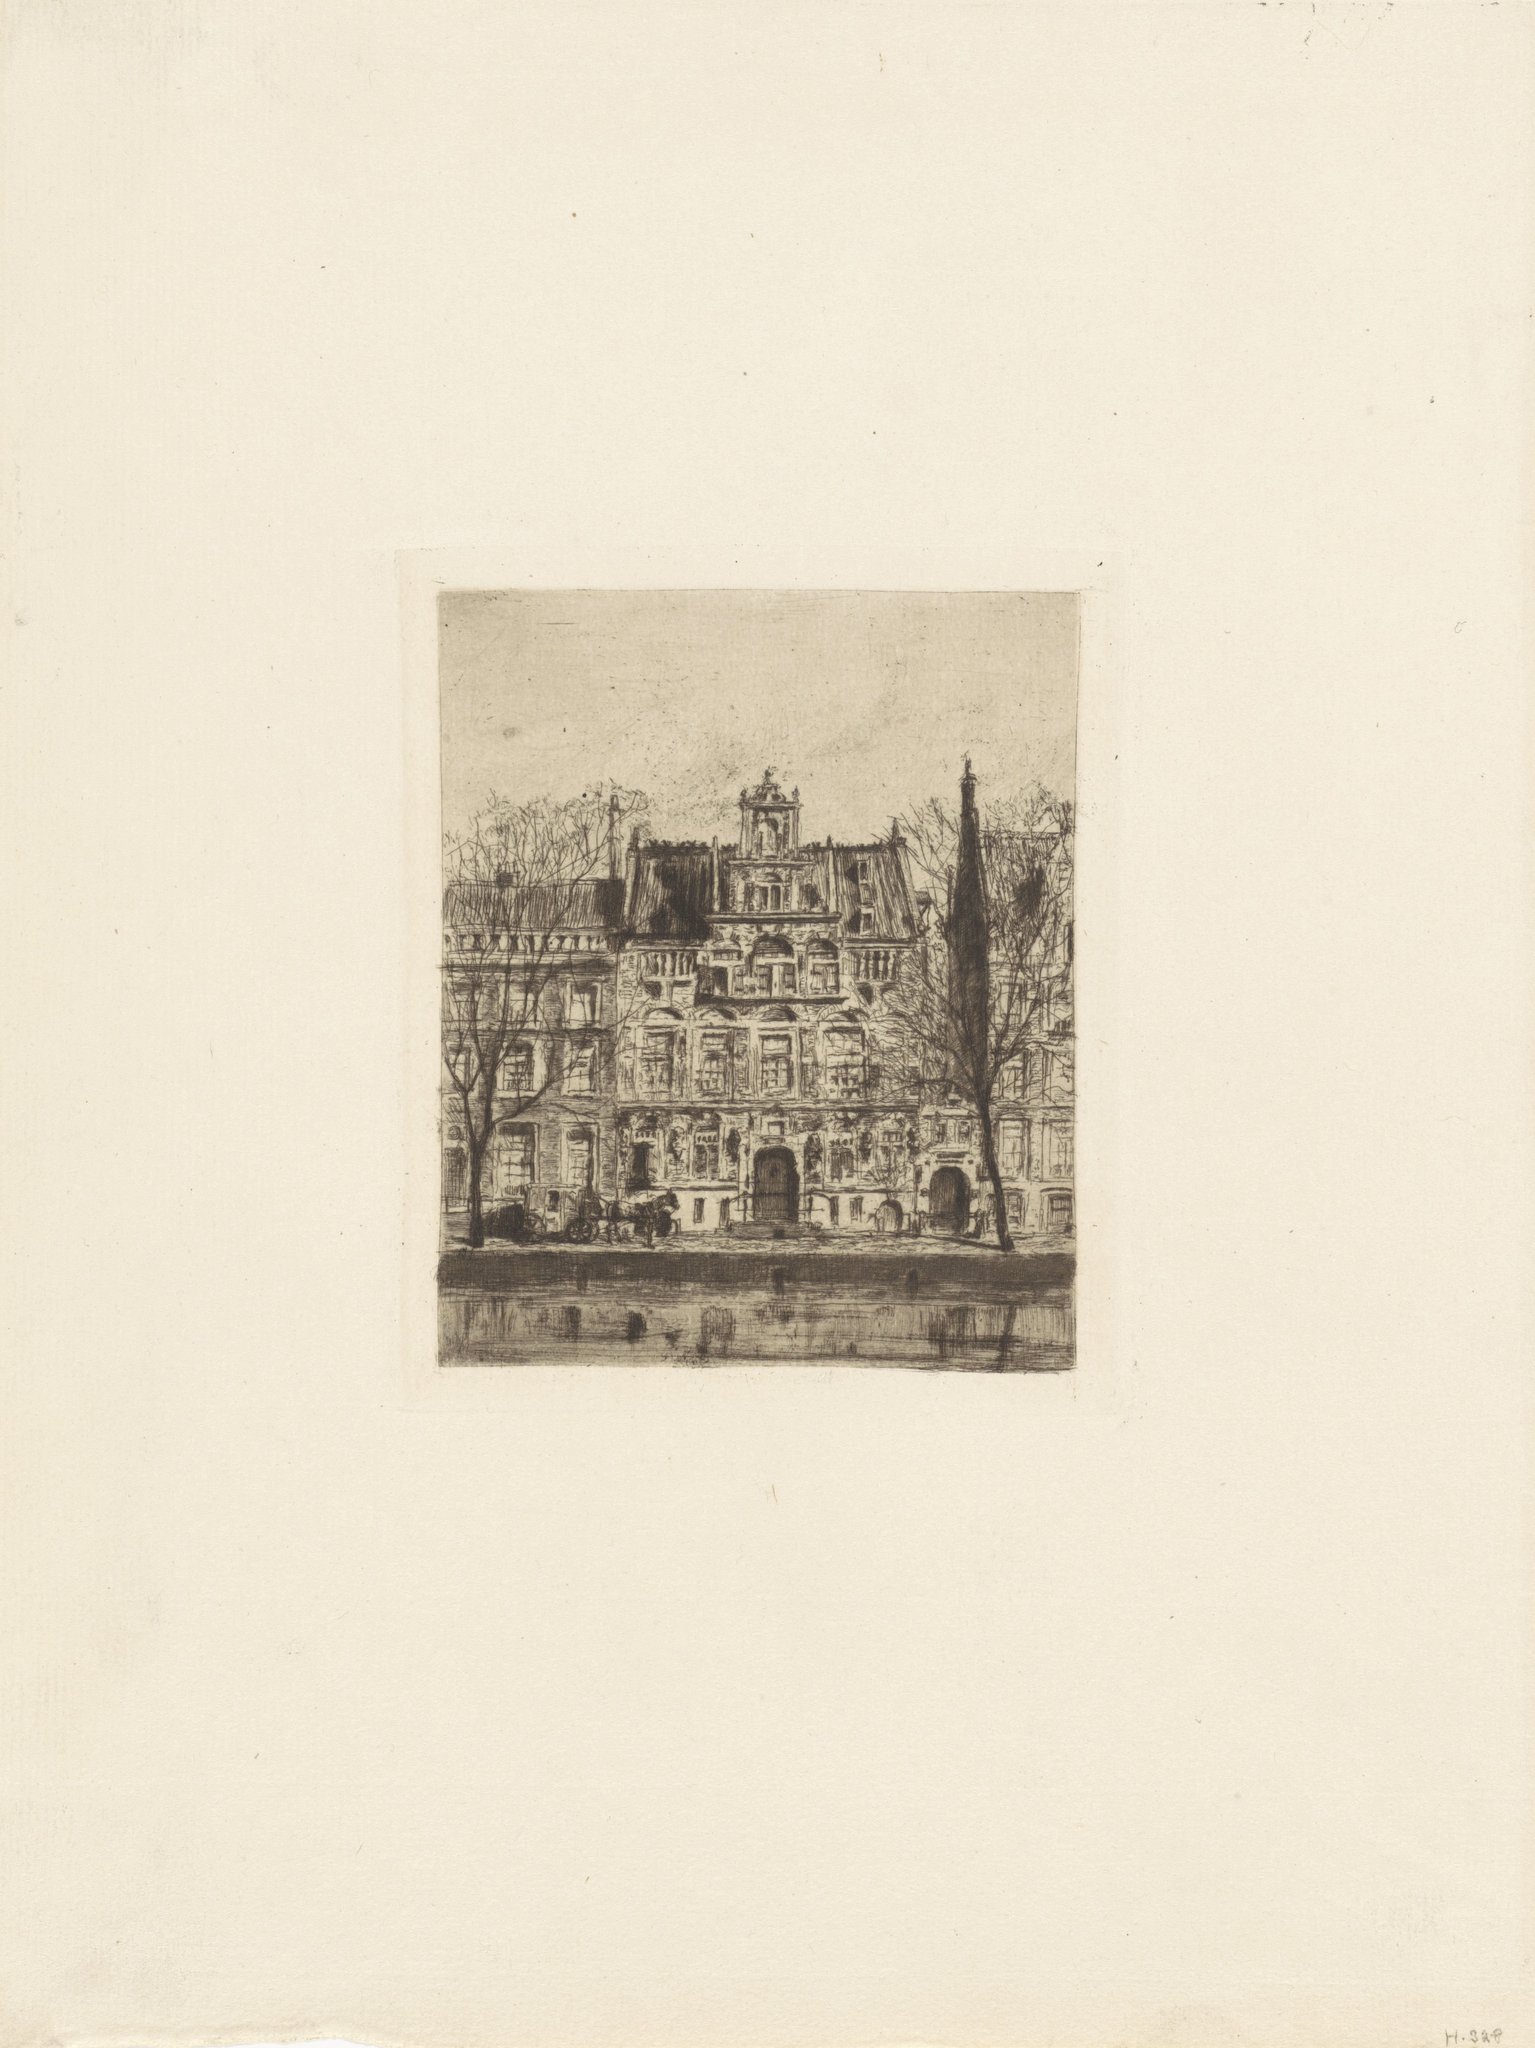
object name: print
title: Huis met de Hoofden te Amsterdam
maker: frans schikkinger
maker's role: print maker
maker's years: 1838-1902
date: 1848-1902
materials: paper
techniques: drypoint, etching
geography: amsterdam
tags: the usual house or row of houses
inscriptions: collector's mark: Lugt 2760, collector's mark: Lugt 2228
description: Het Huis met de Hoofden aan de Keizersgracht te Amsterdam.